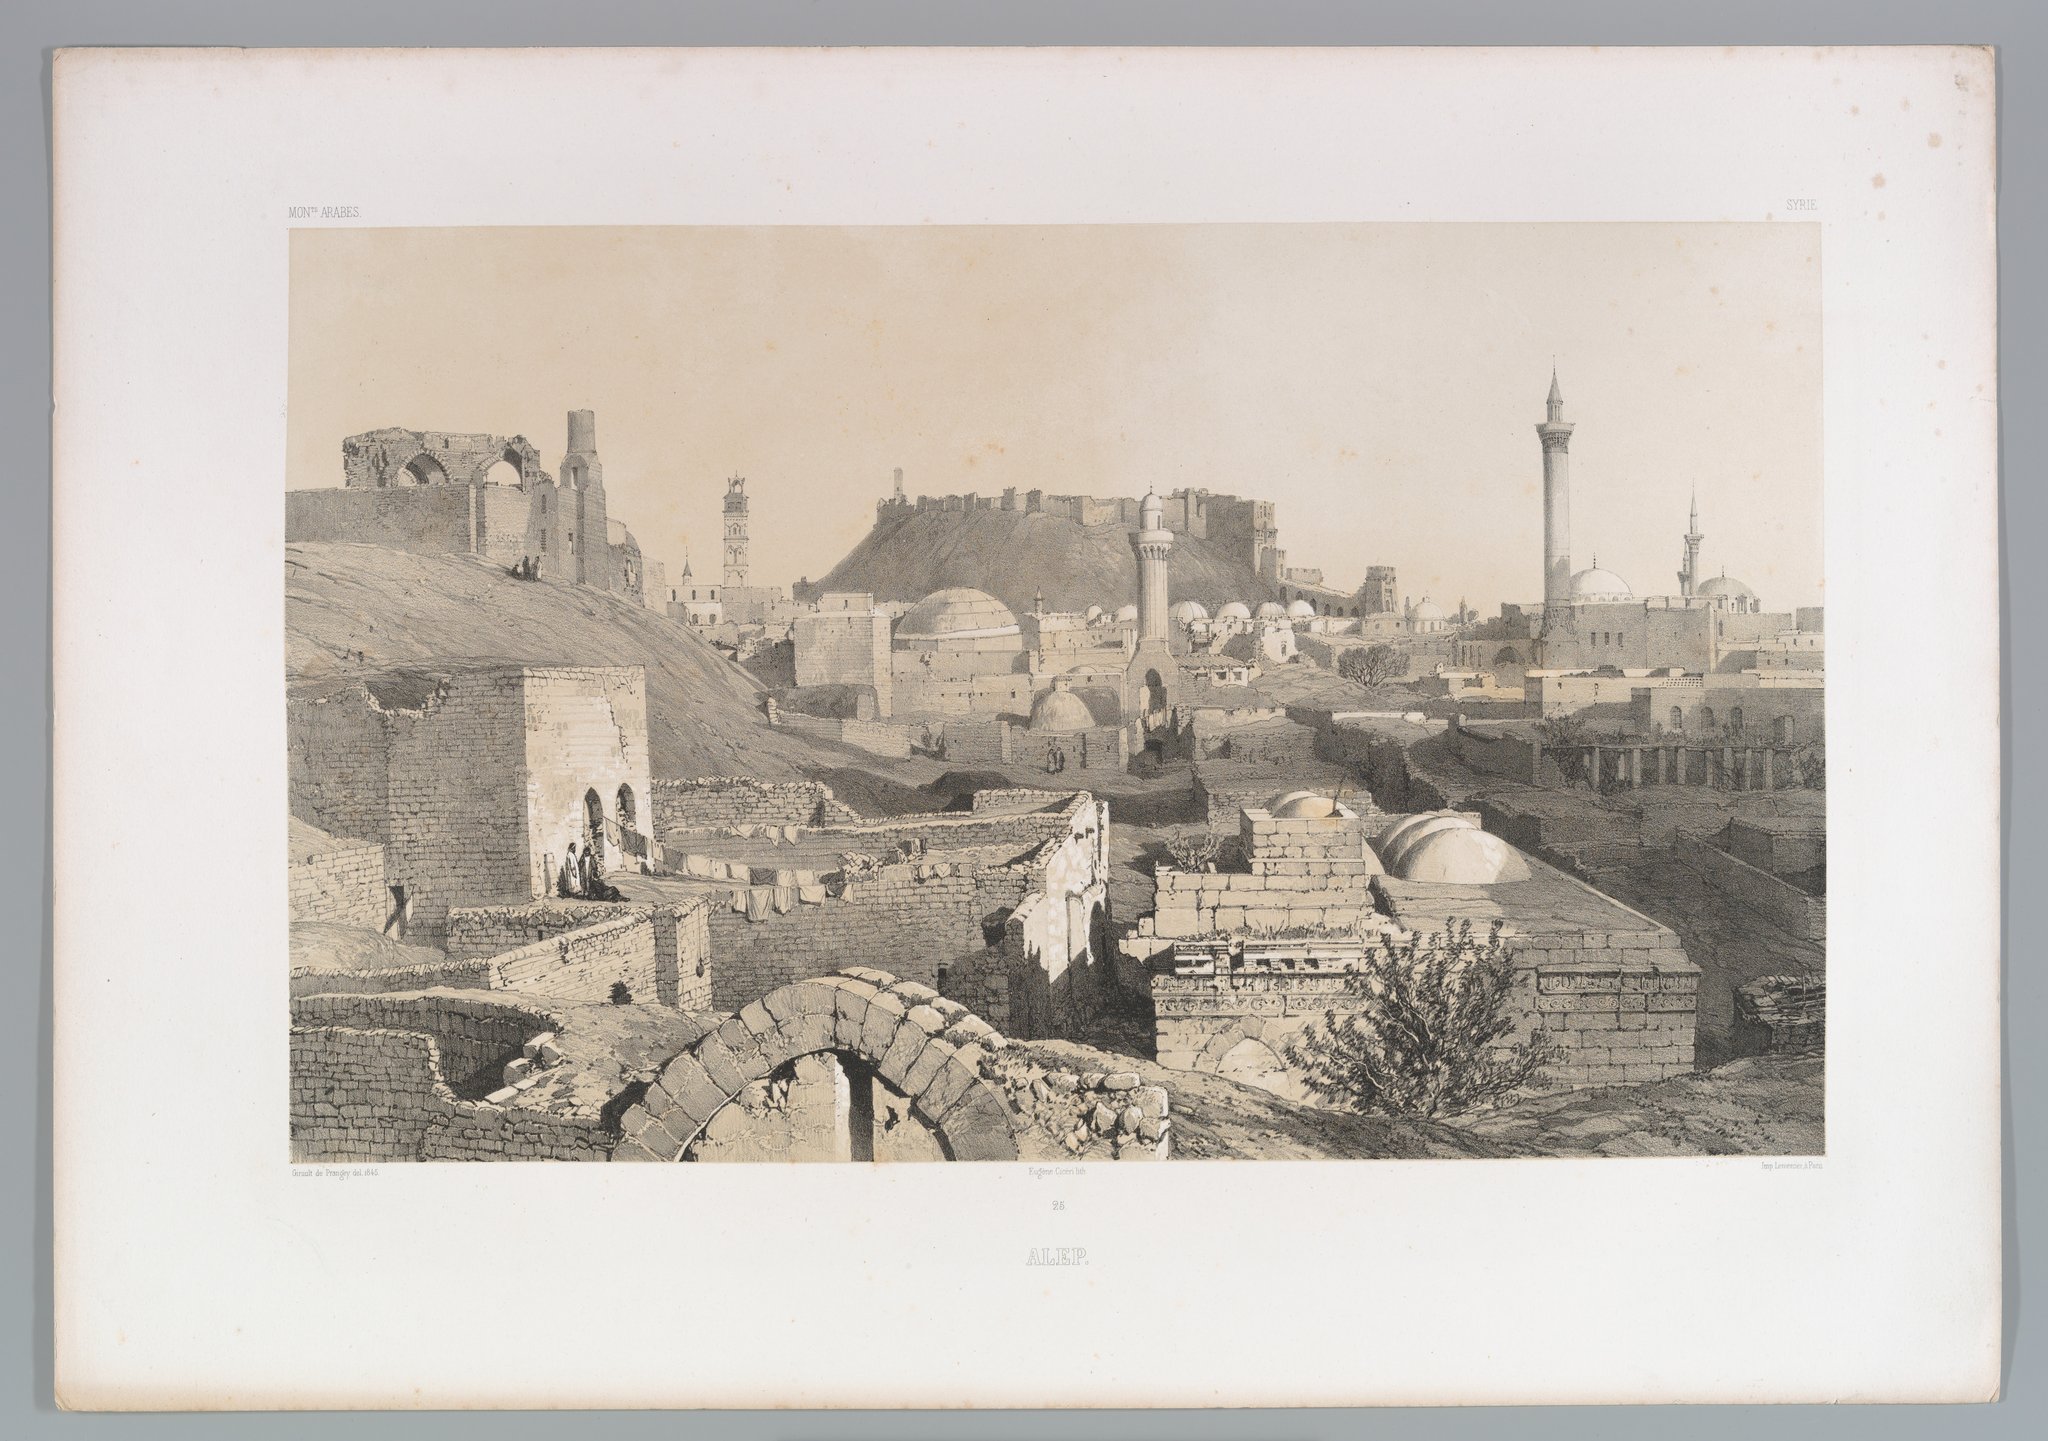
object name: lithograph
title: Alep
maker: joseph-philibert girault de prangey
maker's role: artist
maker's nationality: french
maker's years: 1804-1892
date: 1843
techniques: lithograph